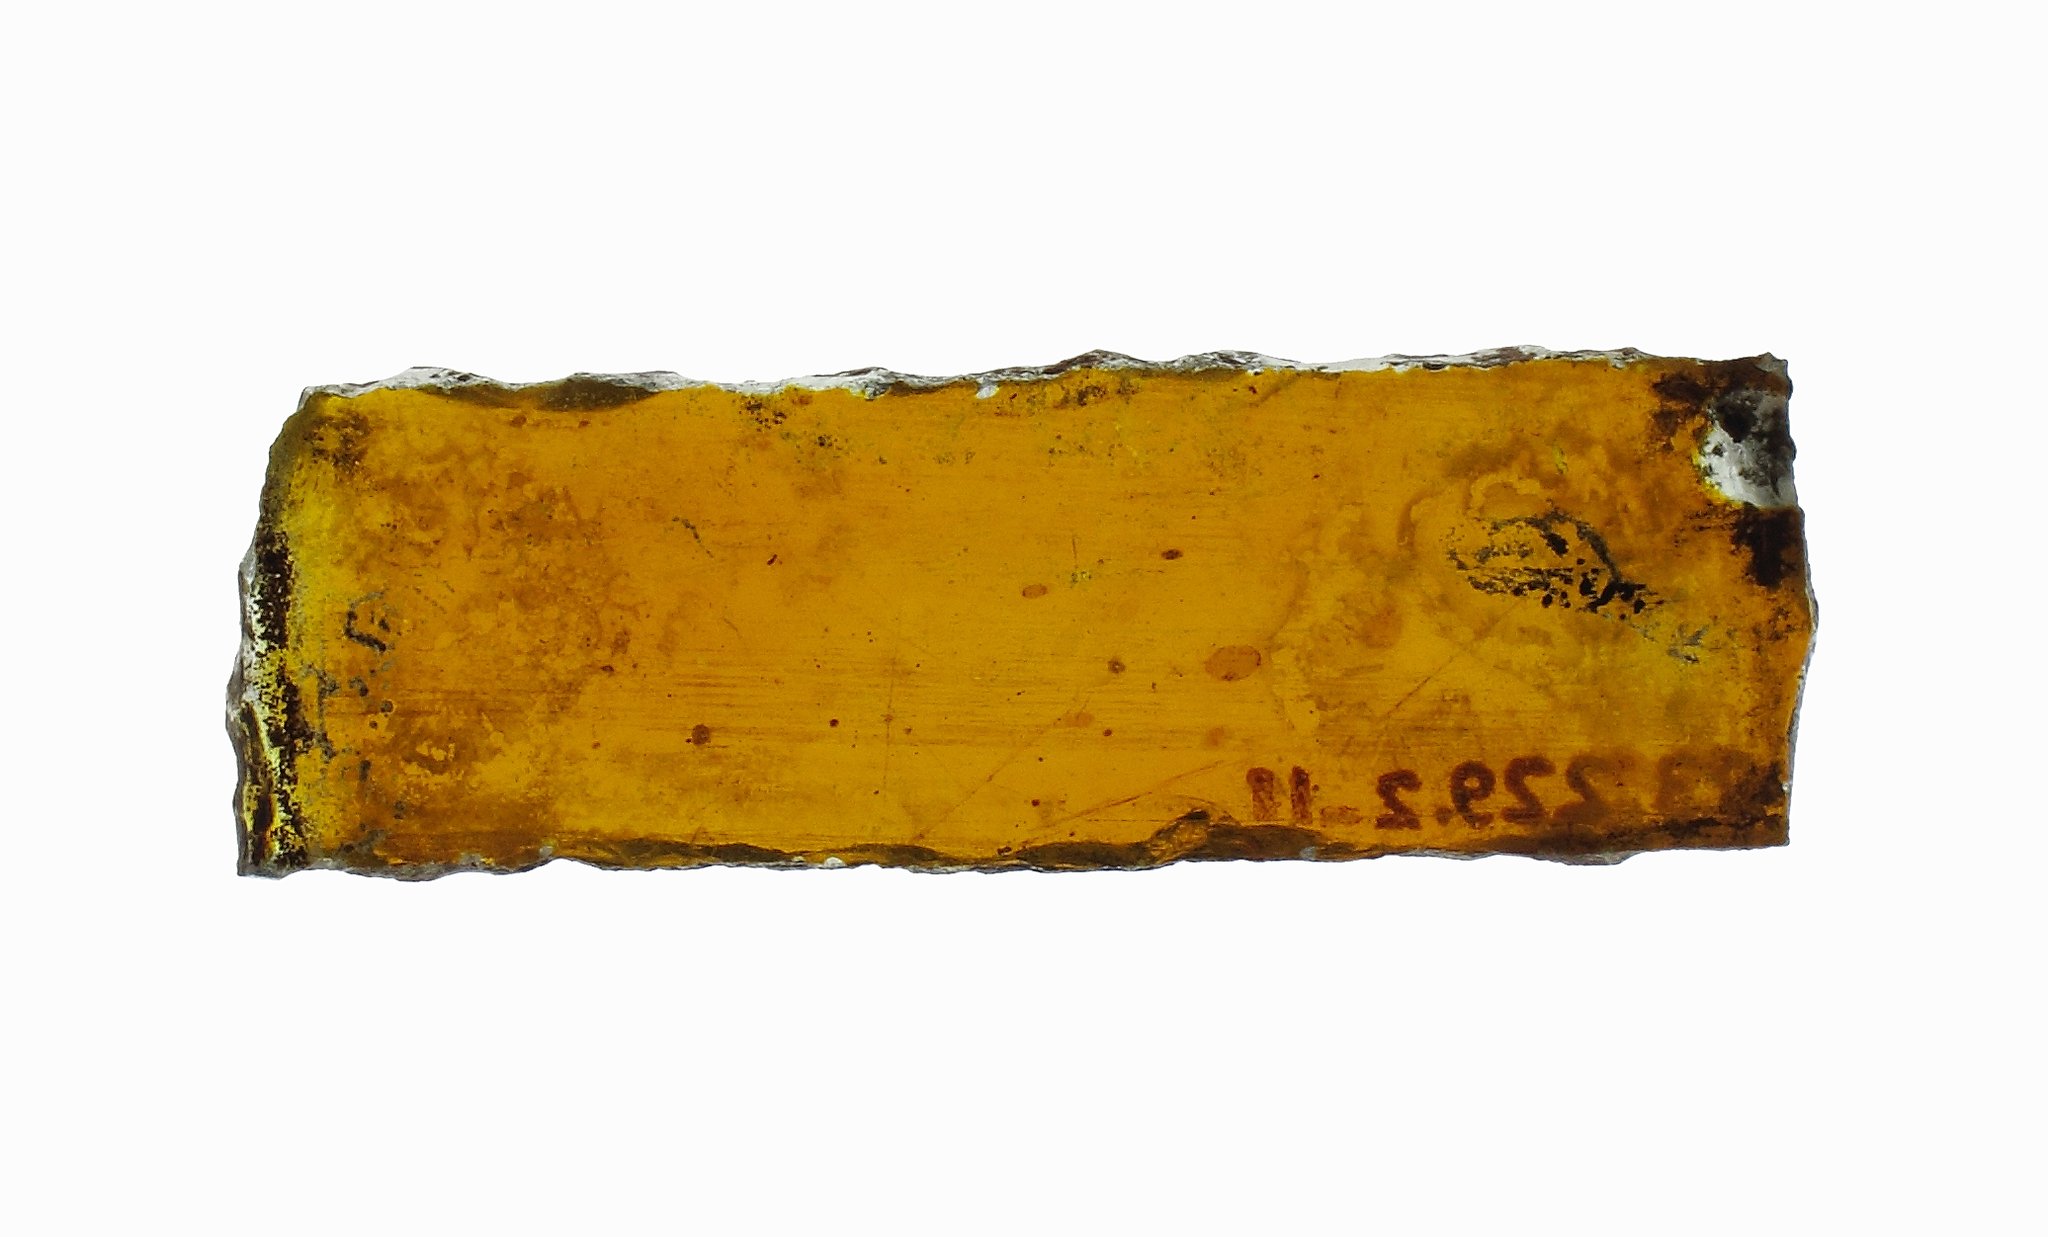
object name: fragment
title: Glass Fragment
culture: french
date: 1301-1500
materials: glass, metal